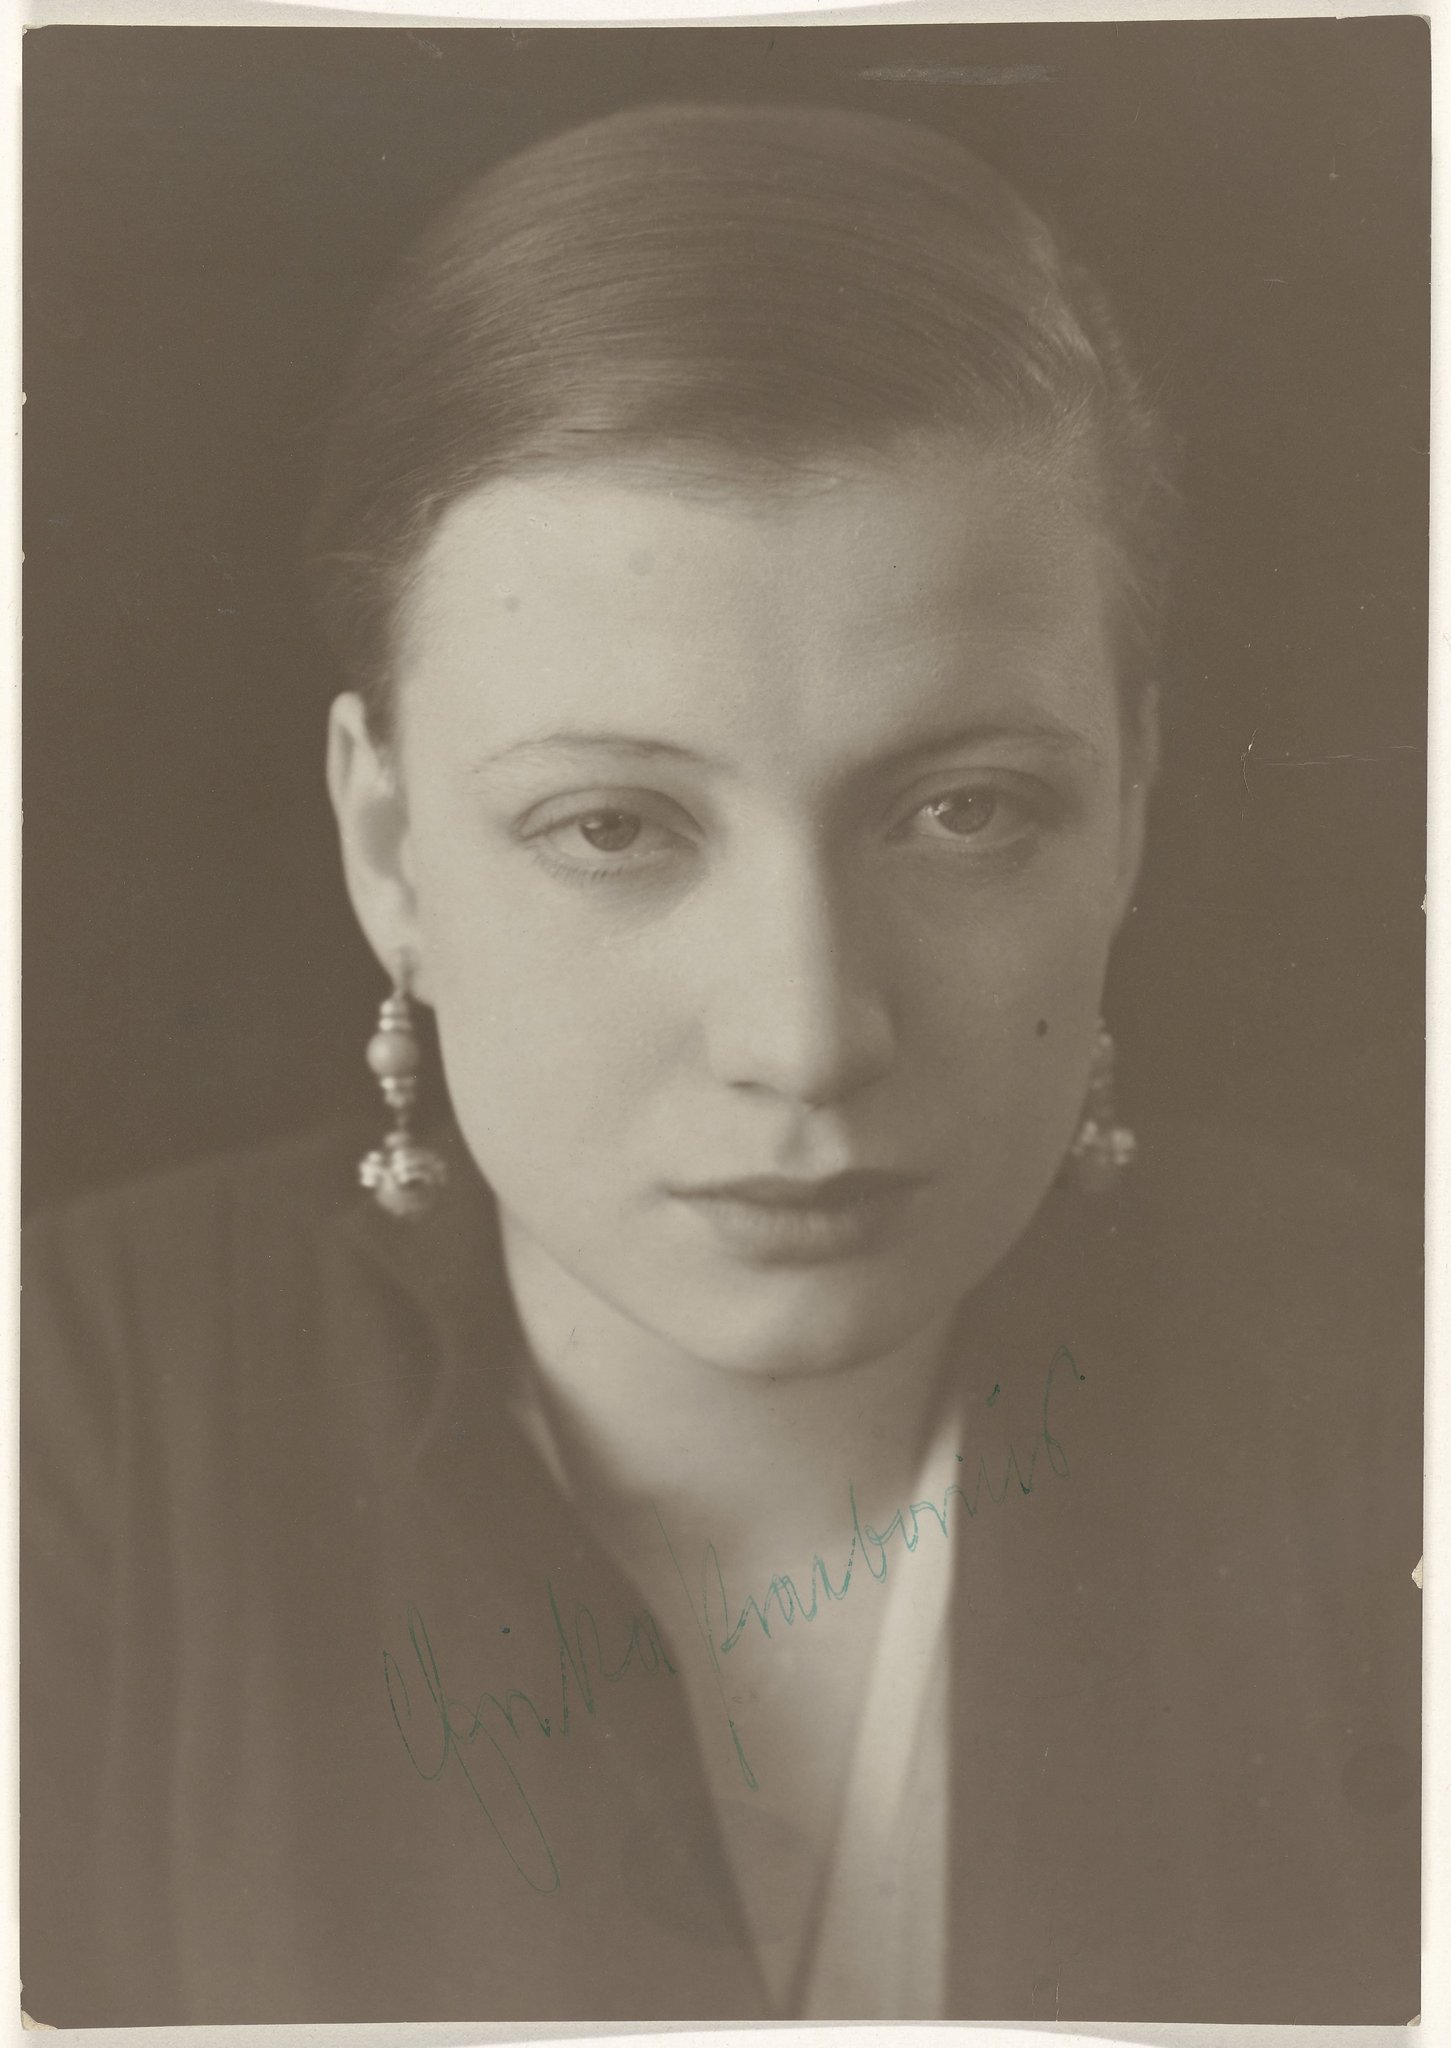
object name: photograph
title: Portret van een actrice met grote oorbellen, gesigneerd Frika Prazbovint[onz]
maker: Anonymous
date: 1920-1940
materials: photographic support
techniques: gelatin silver print